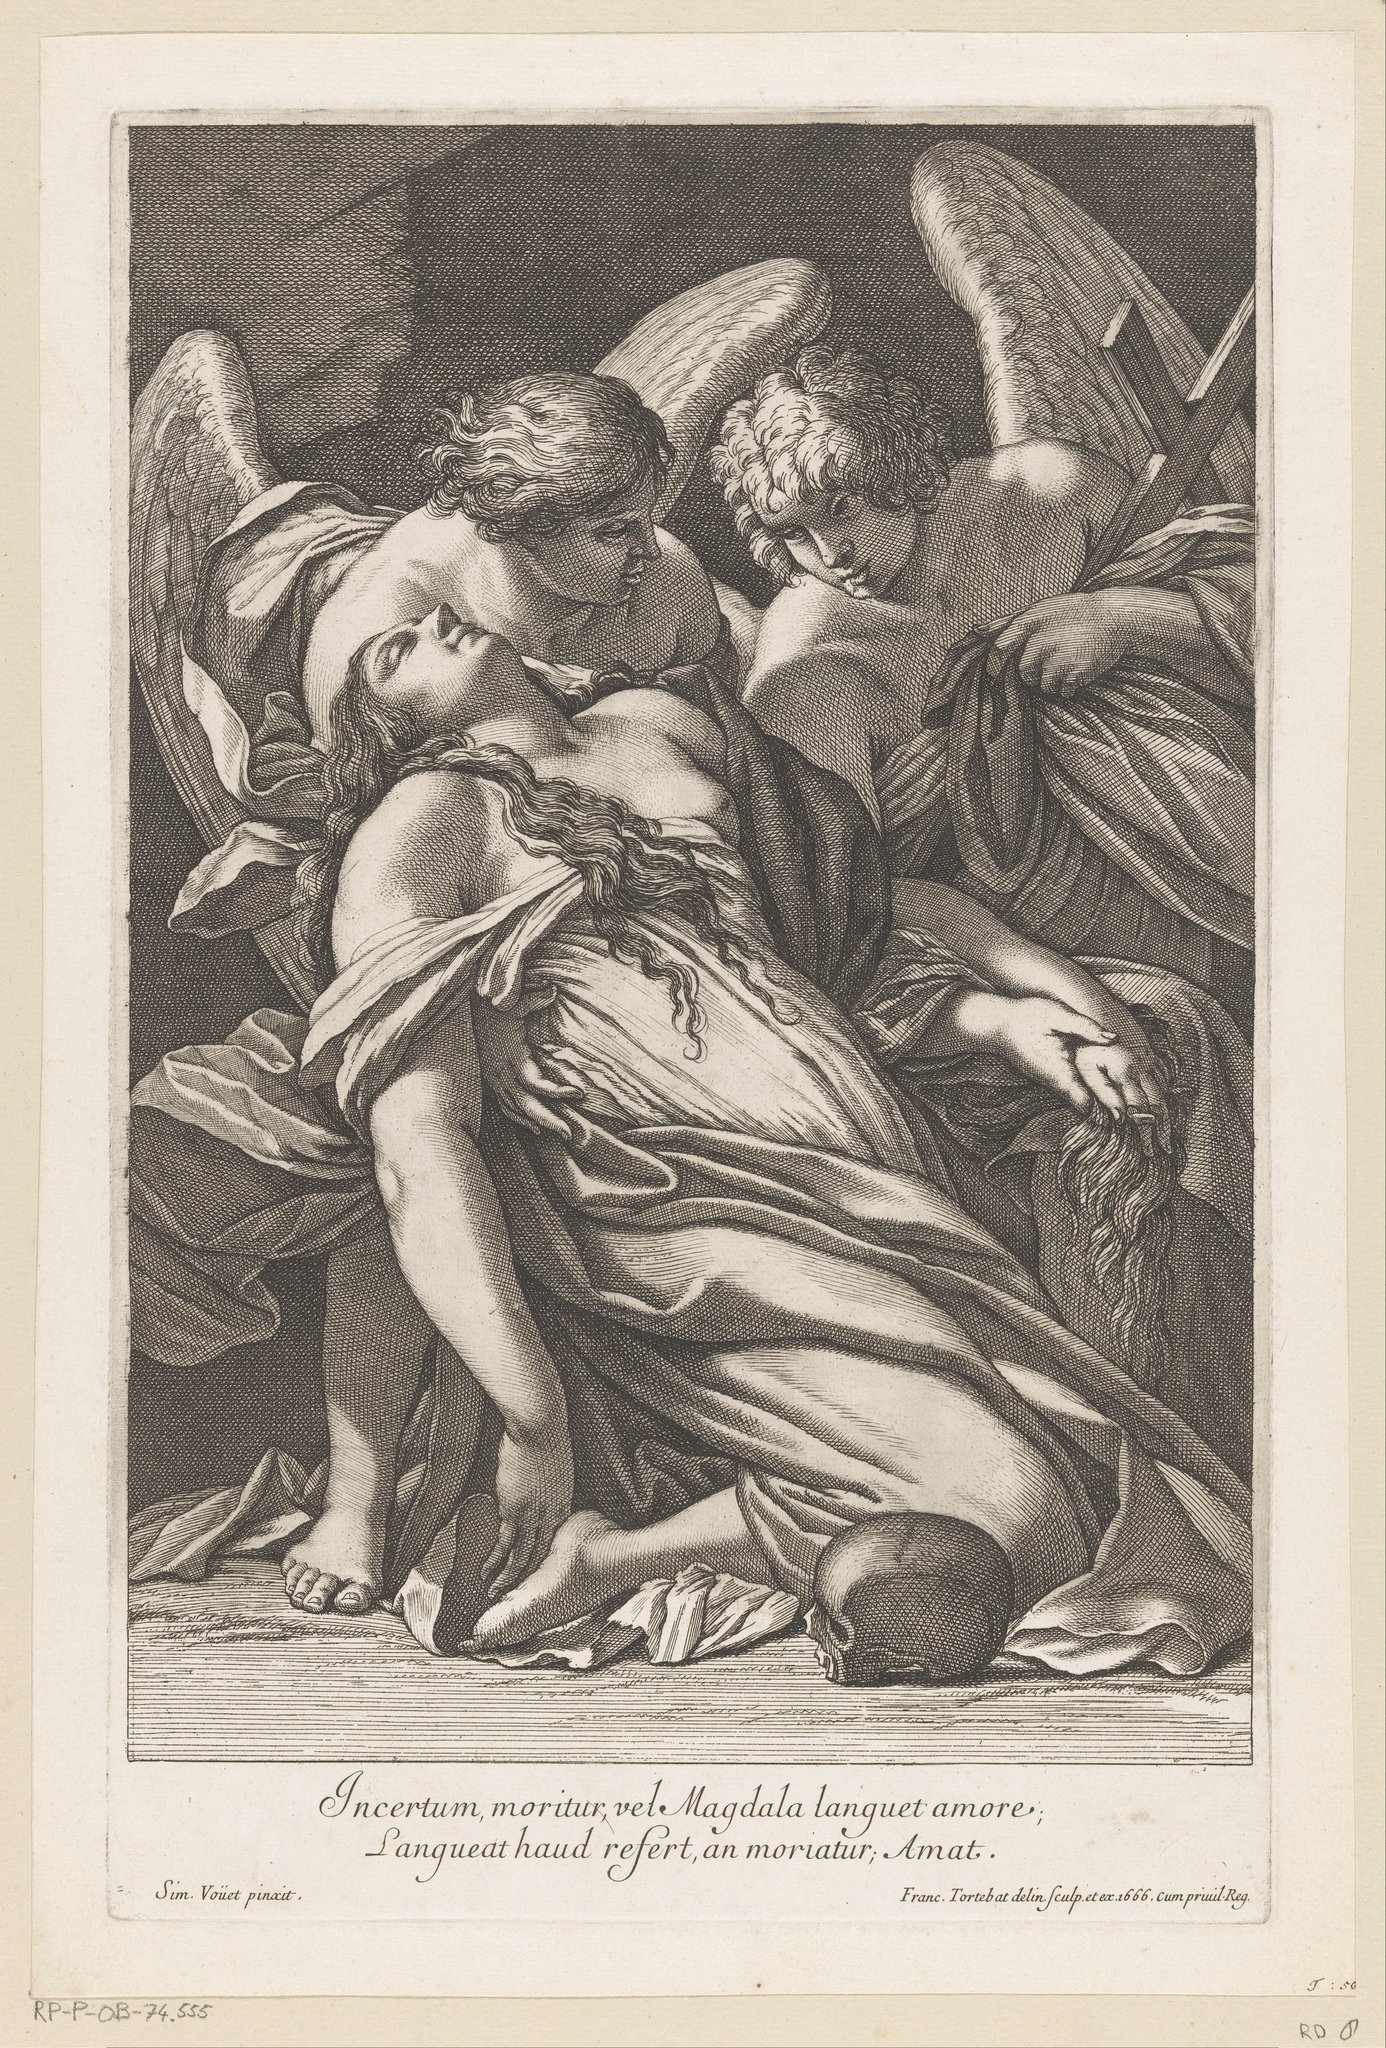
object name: print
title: Dood van Magdalena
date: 1664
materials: paper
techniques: engraving, etching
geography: paris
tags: st. mary magdalene dies in the wilderness, supported by angels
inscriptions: collector's mark: Lugt 240, inscription: ‘T : 50’